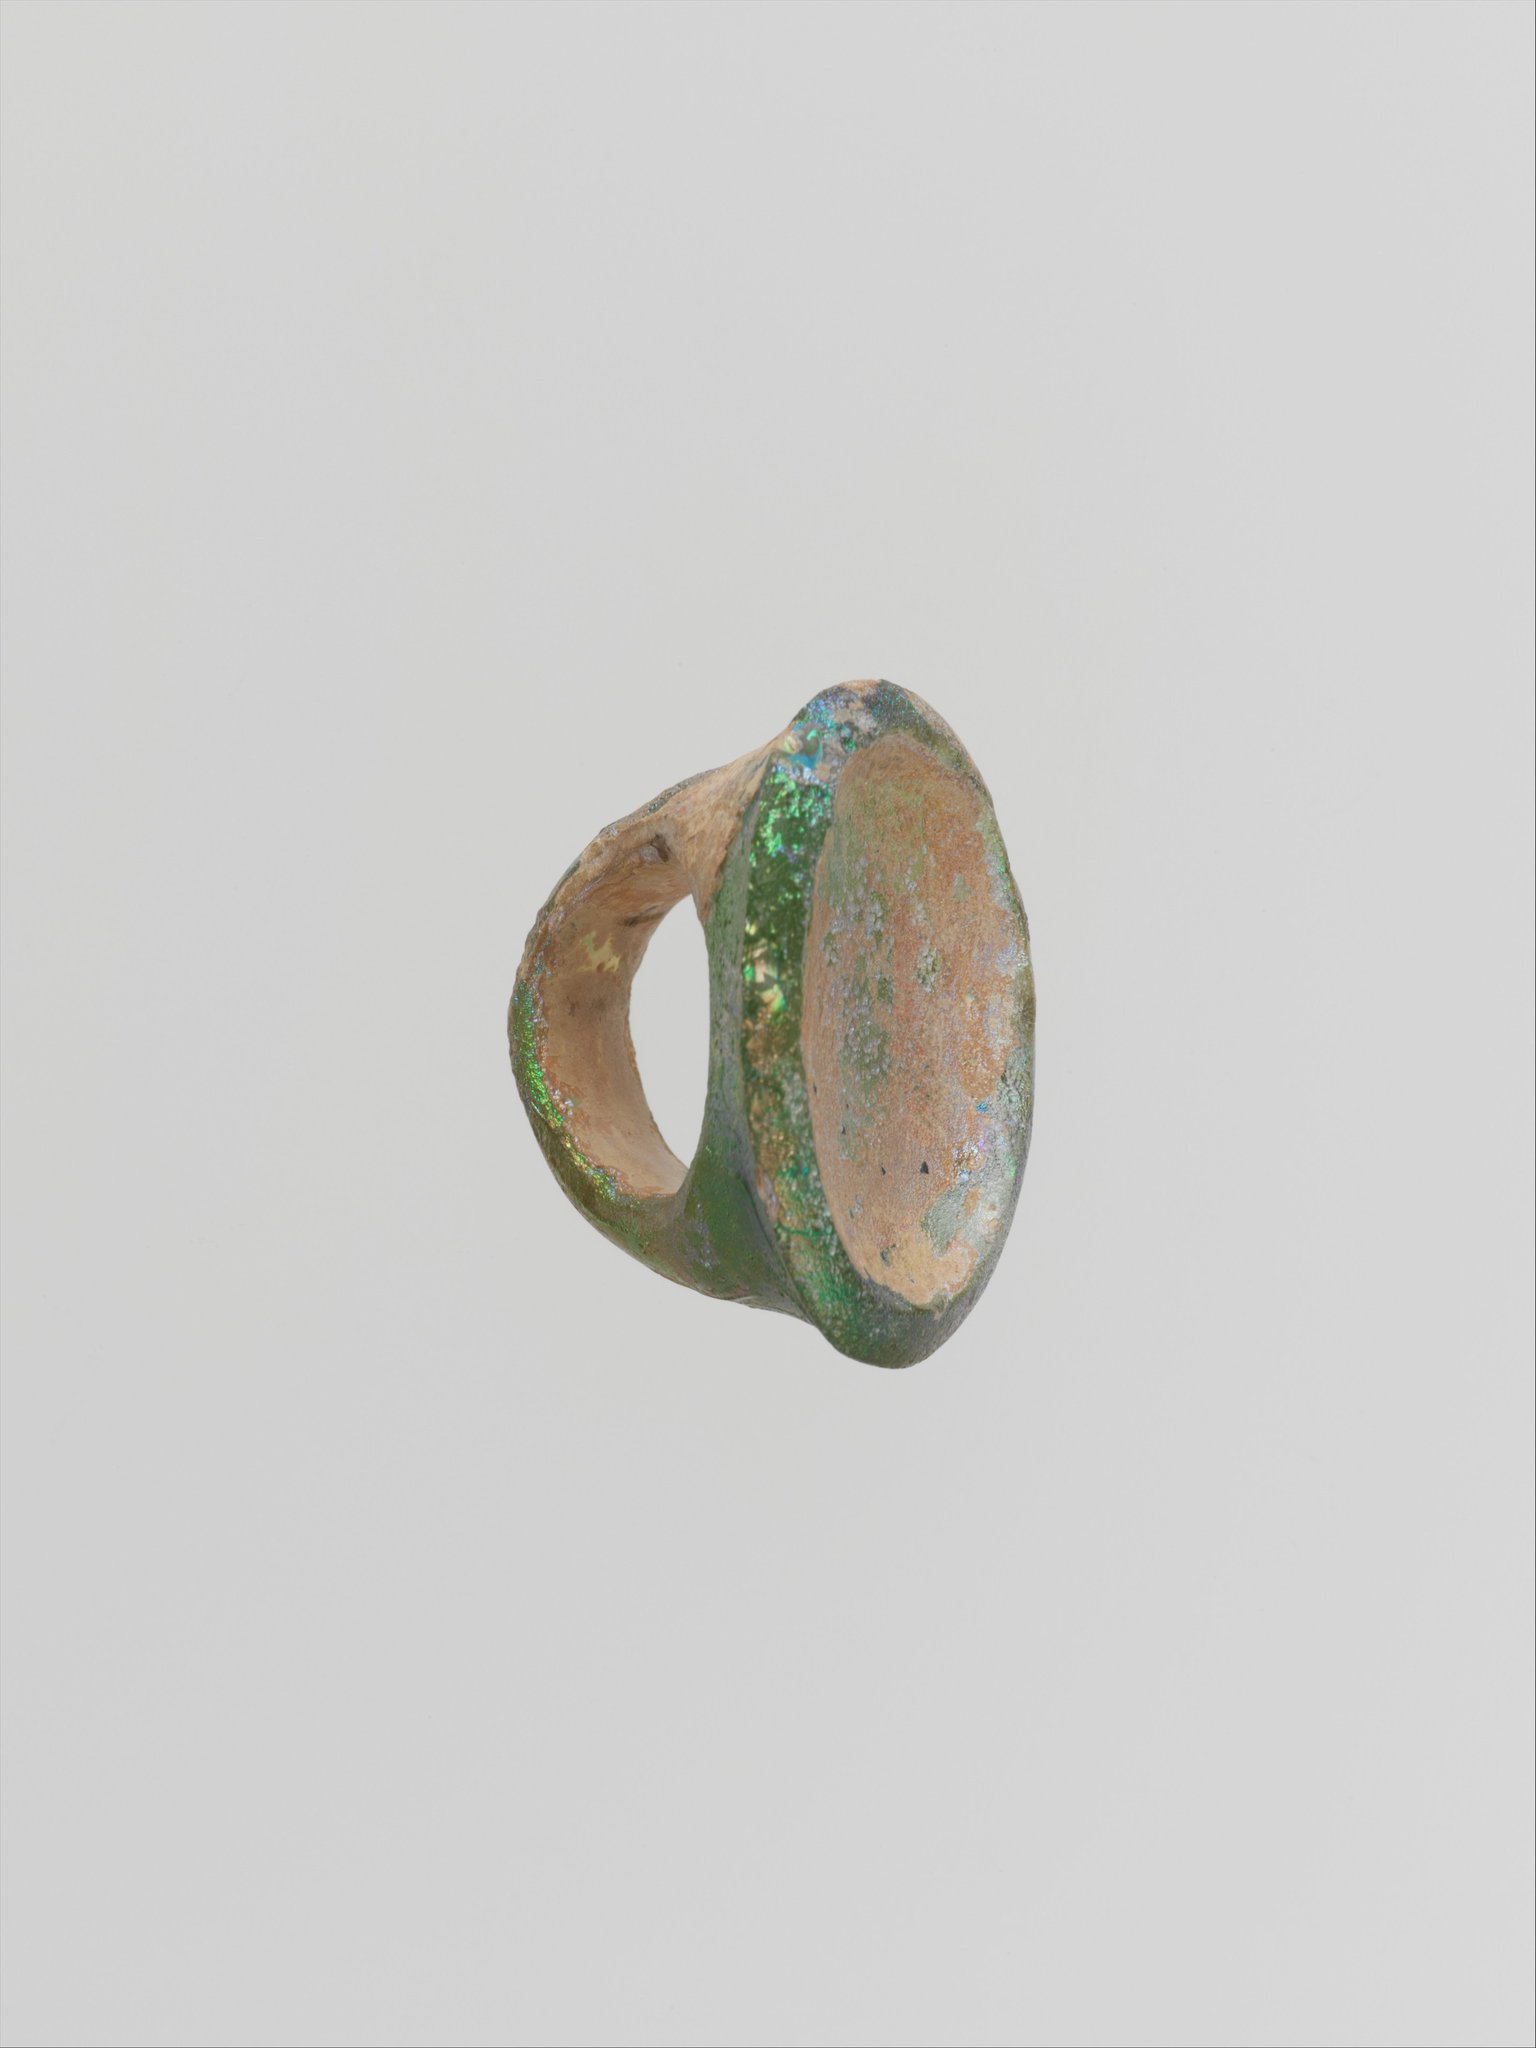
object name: ring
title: Glass finger ring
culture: greek, eastern mediterranean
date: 300-101 BCE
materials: glass